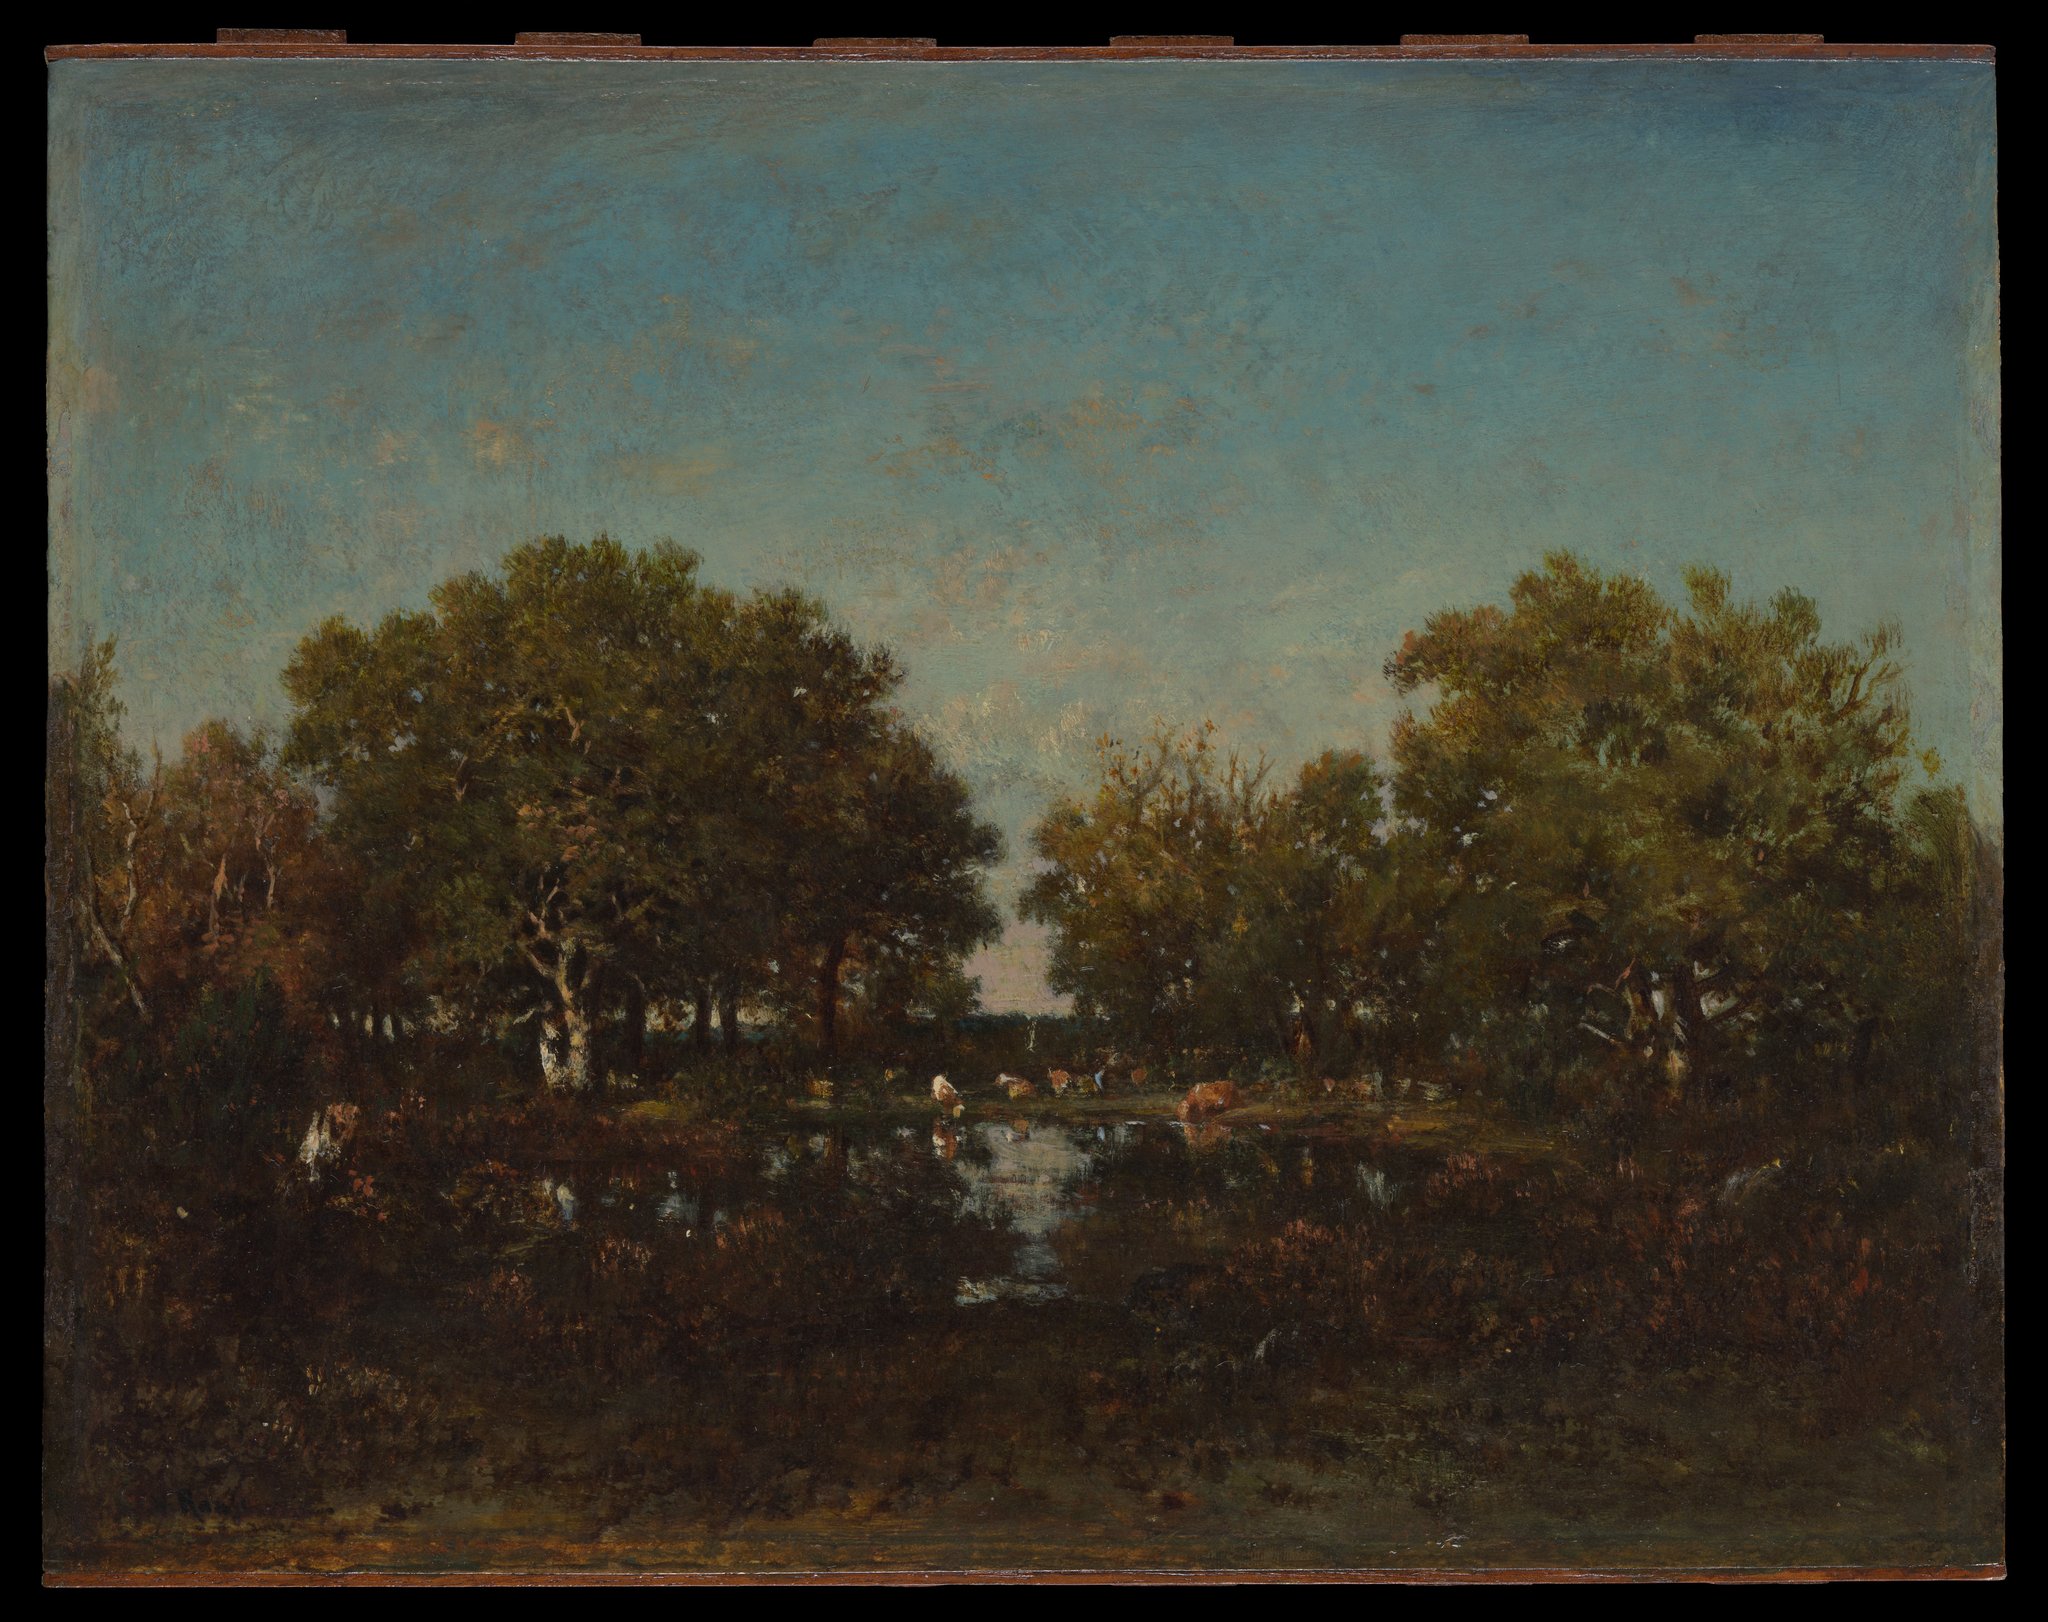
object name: painting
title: The Pool (Memory of the Forest of Chambord)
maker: théodore rousseau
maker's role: artist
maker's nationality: french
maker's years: 1812-1867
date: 1839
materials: oil, wood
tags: forests,landscapes